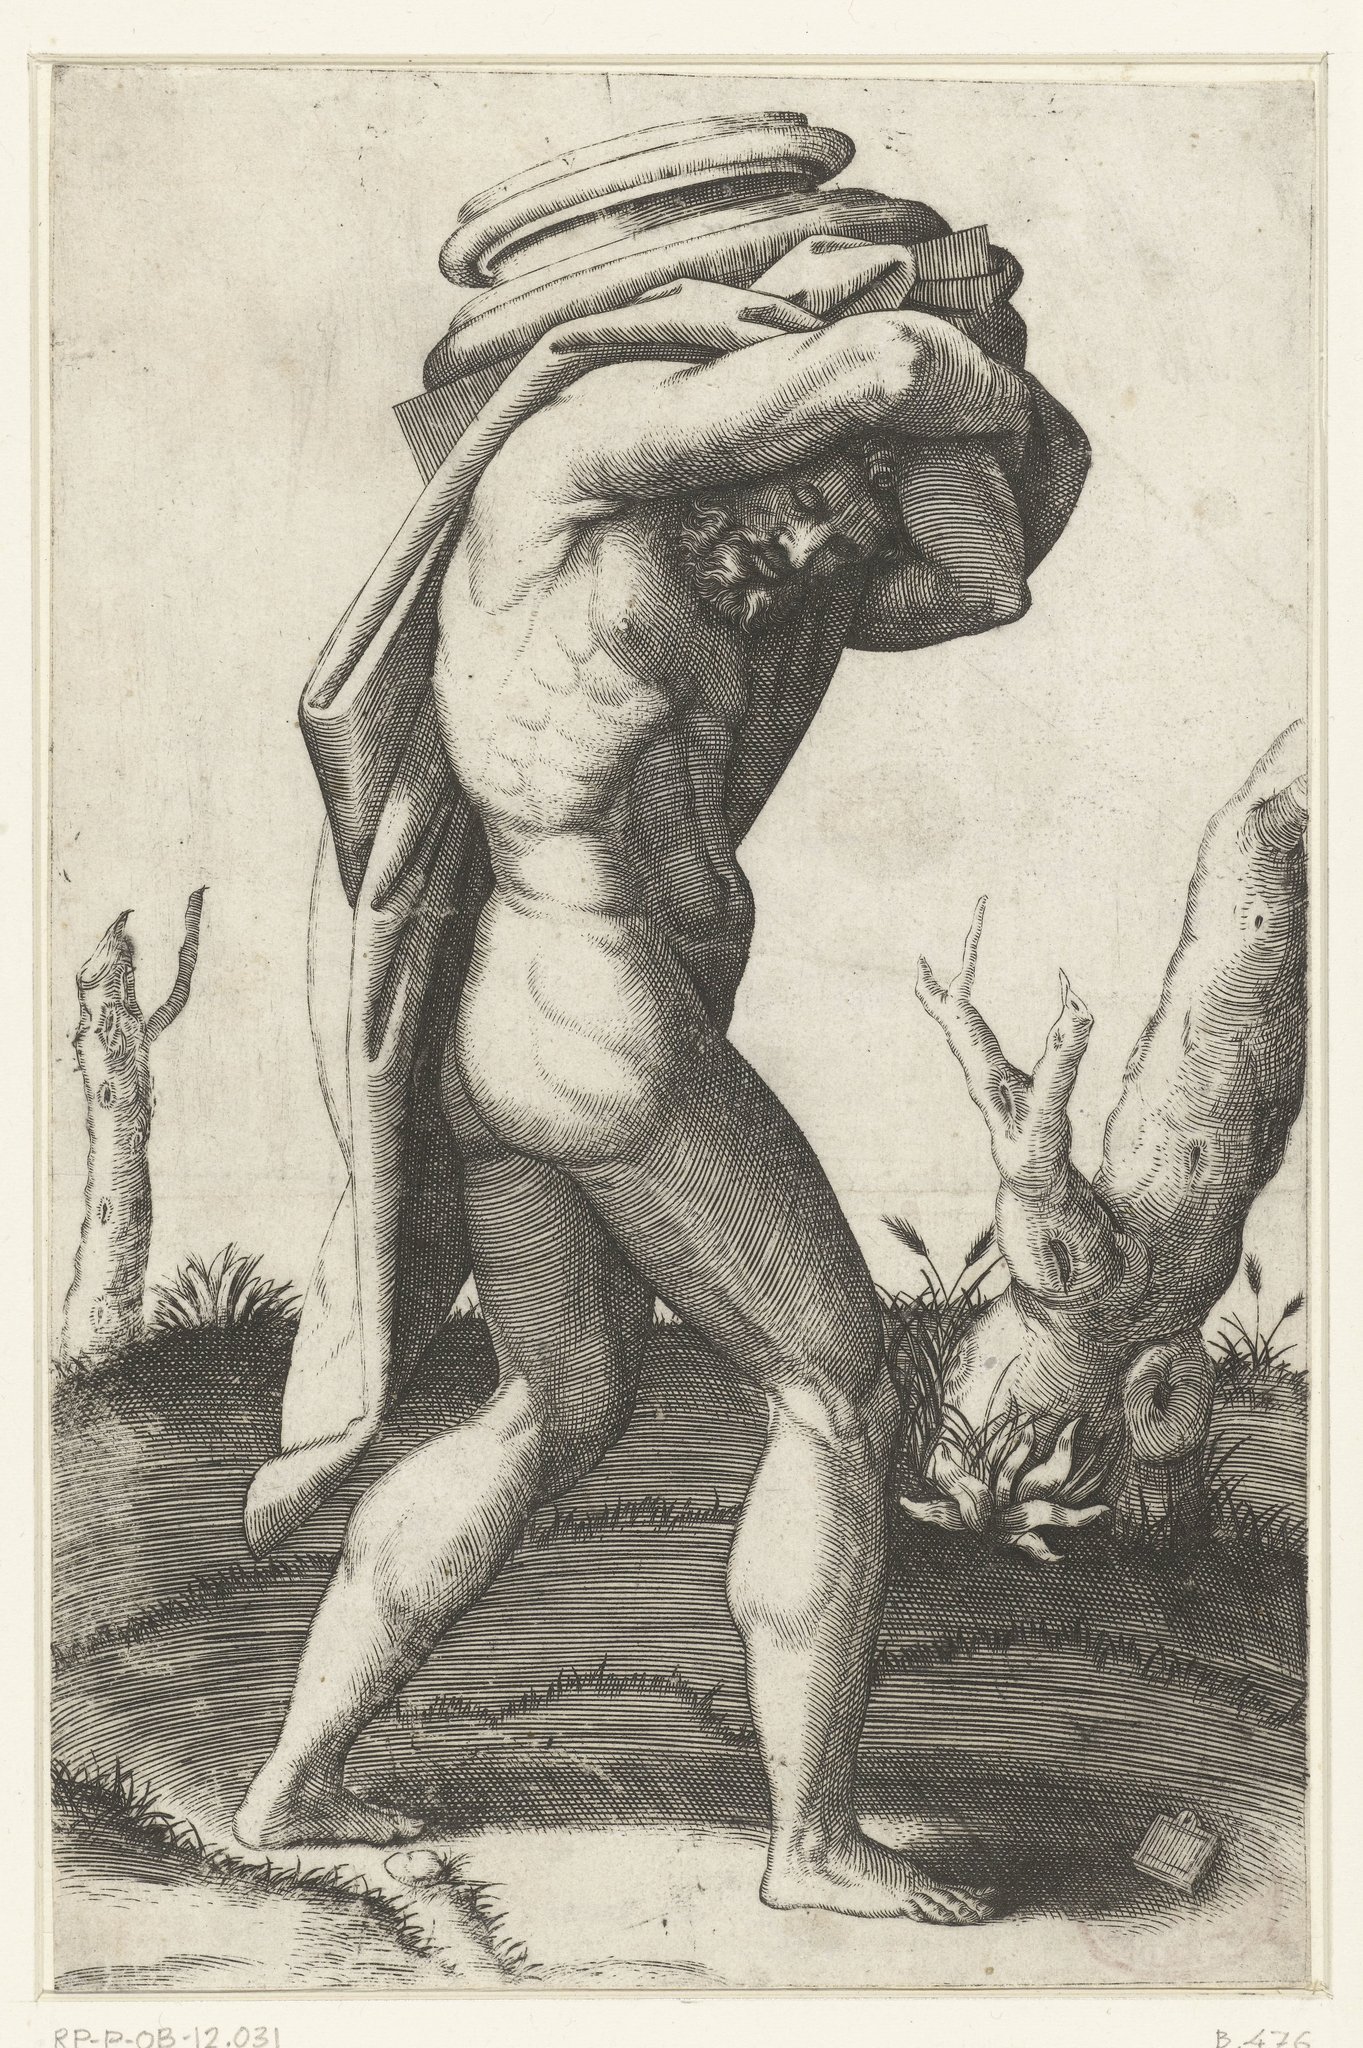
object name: print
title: Naakte man draagt basis van zuil op zijn rug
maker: marcantonio raimondi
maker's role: print maker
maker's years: 1470-1534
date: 1517-1520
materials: paper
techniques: engraving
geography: italy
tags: the (nude) human figure; 'corpo humano' (ripa), male sex; man, carrying something on the head or on the shoulders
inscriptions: collector's mark: ‘F Rechberger 1812’ Lugt 2133, collector's mark: Lugt 12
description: Het is onduidelijk op welk voorbeeld Raimondi zich baseerde. Een prent van zijn leerling Agostino Veneziano toont een zeer vergelijkbare compositie in spiegelbeeld. Het is denkbaar dat zij beiden teruggrepen naar een ontwerp van Raphael (Shoemaker 1981, p. 140-142).